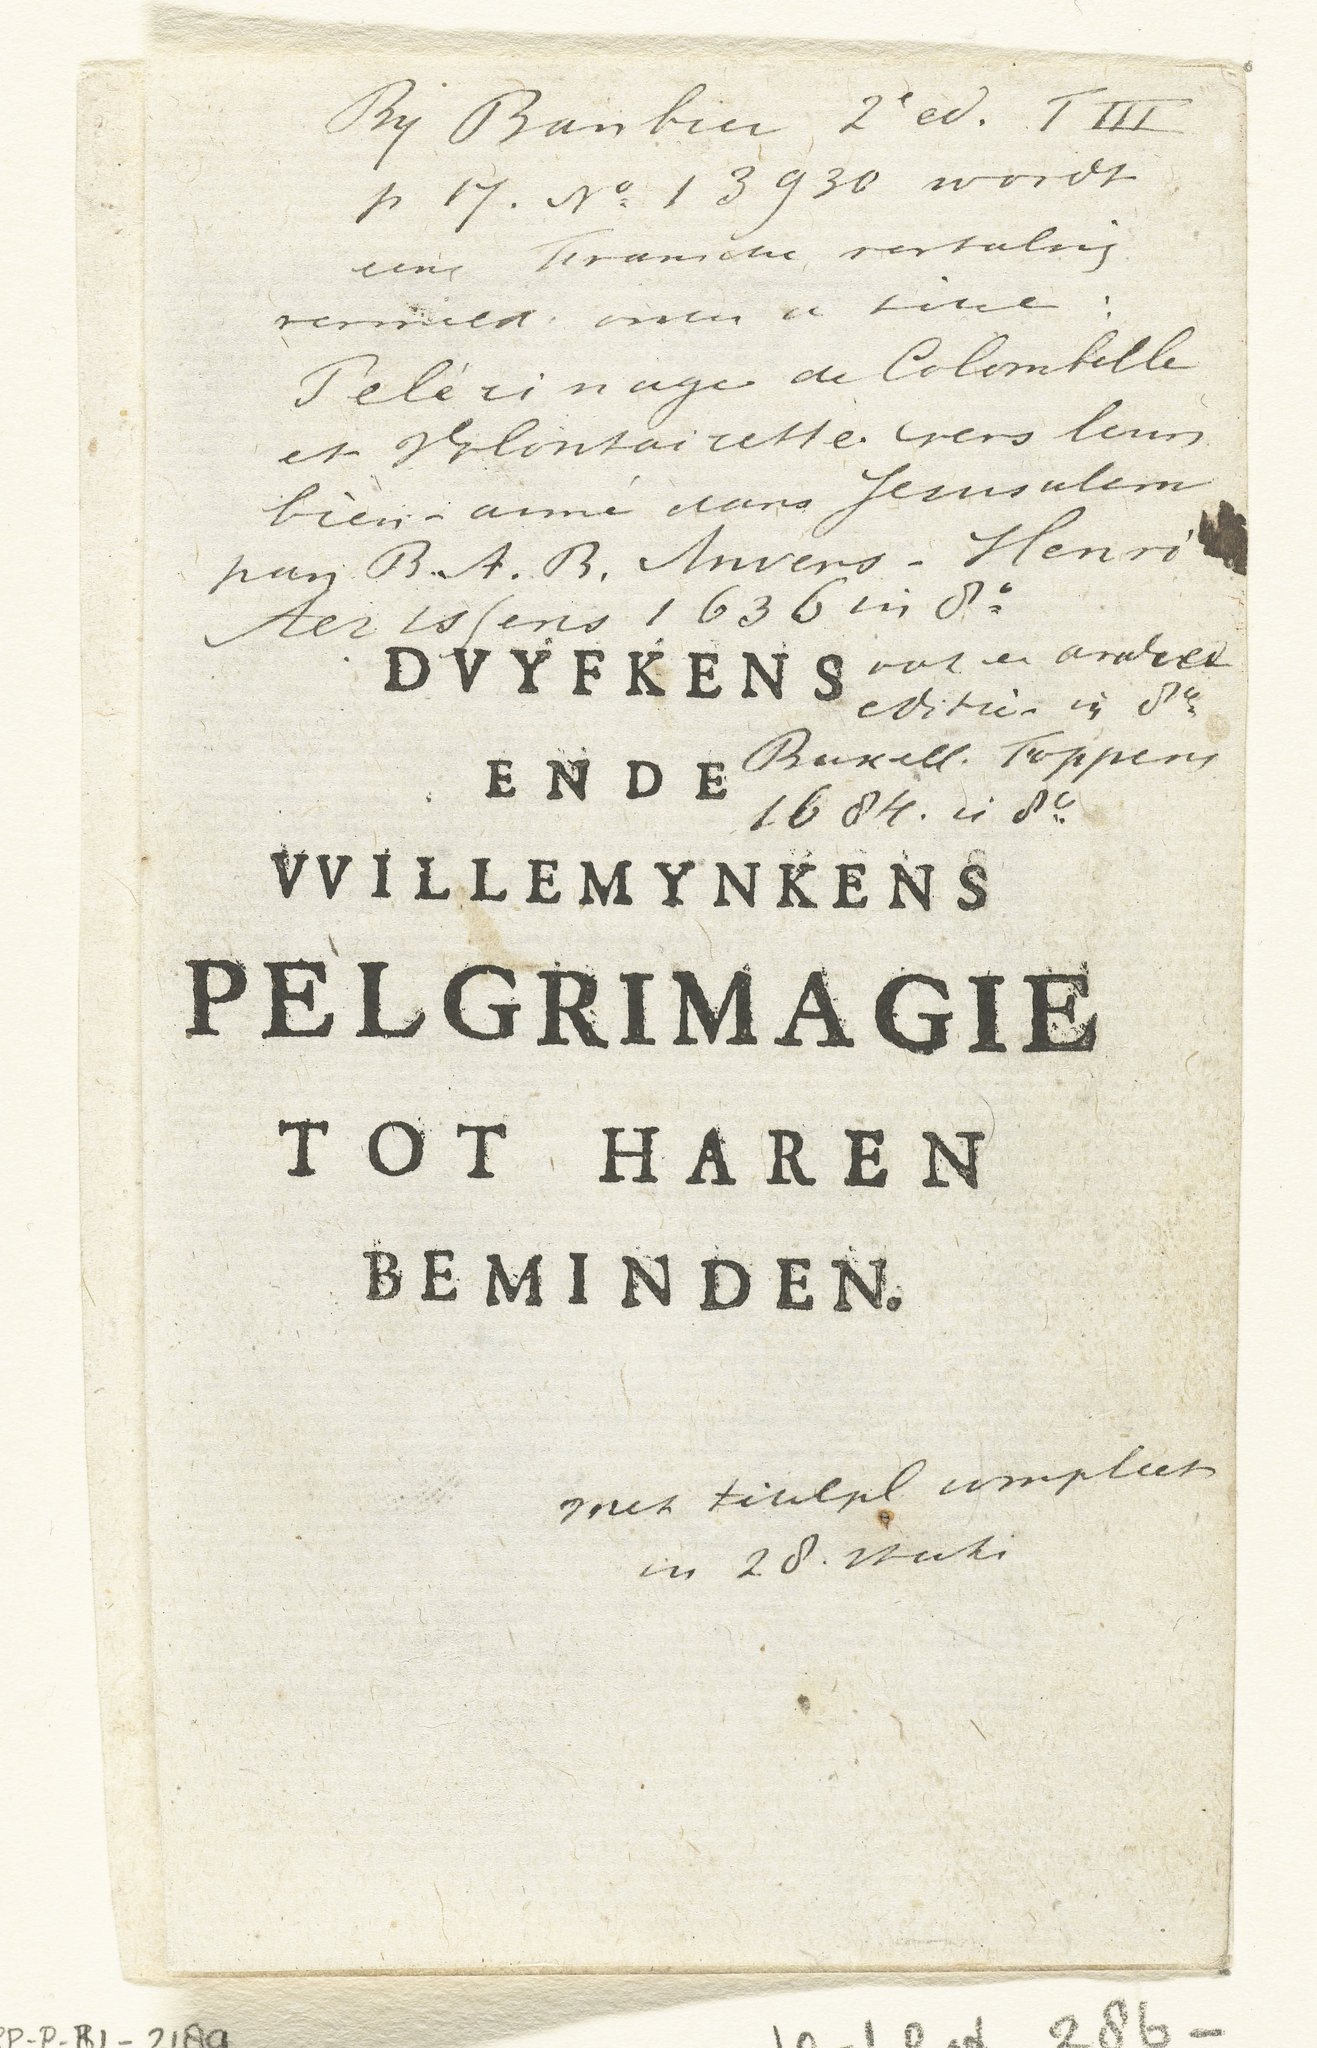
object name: print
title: Duyfkens en Willemynkens pelgrimagie tot haren beminden binnen Iervsalem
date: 1590-1627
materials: paper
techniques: engraving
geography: antwerp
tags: pilgrim(s)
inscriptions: collector's mark: Lugt 2228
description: Omlijsting met titel en krullende bladornamenten en twee vrouwen, de hoofdpersonen Duyfken en Willemynken, gekleed als pelgrims zittend op de ornamenten. Op een los blad staat de zogenaamde Franse titel, een verkorte versie van de titel op de titelpagina.